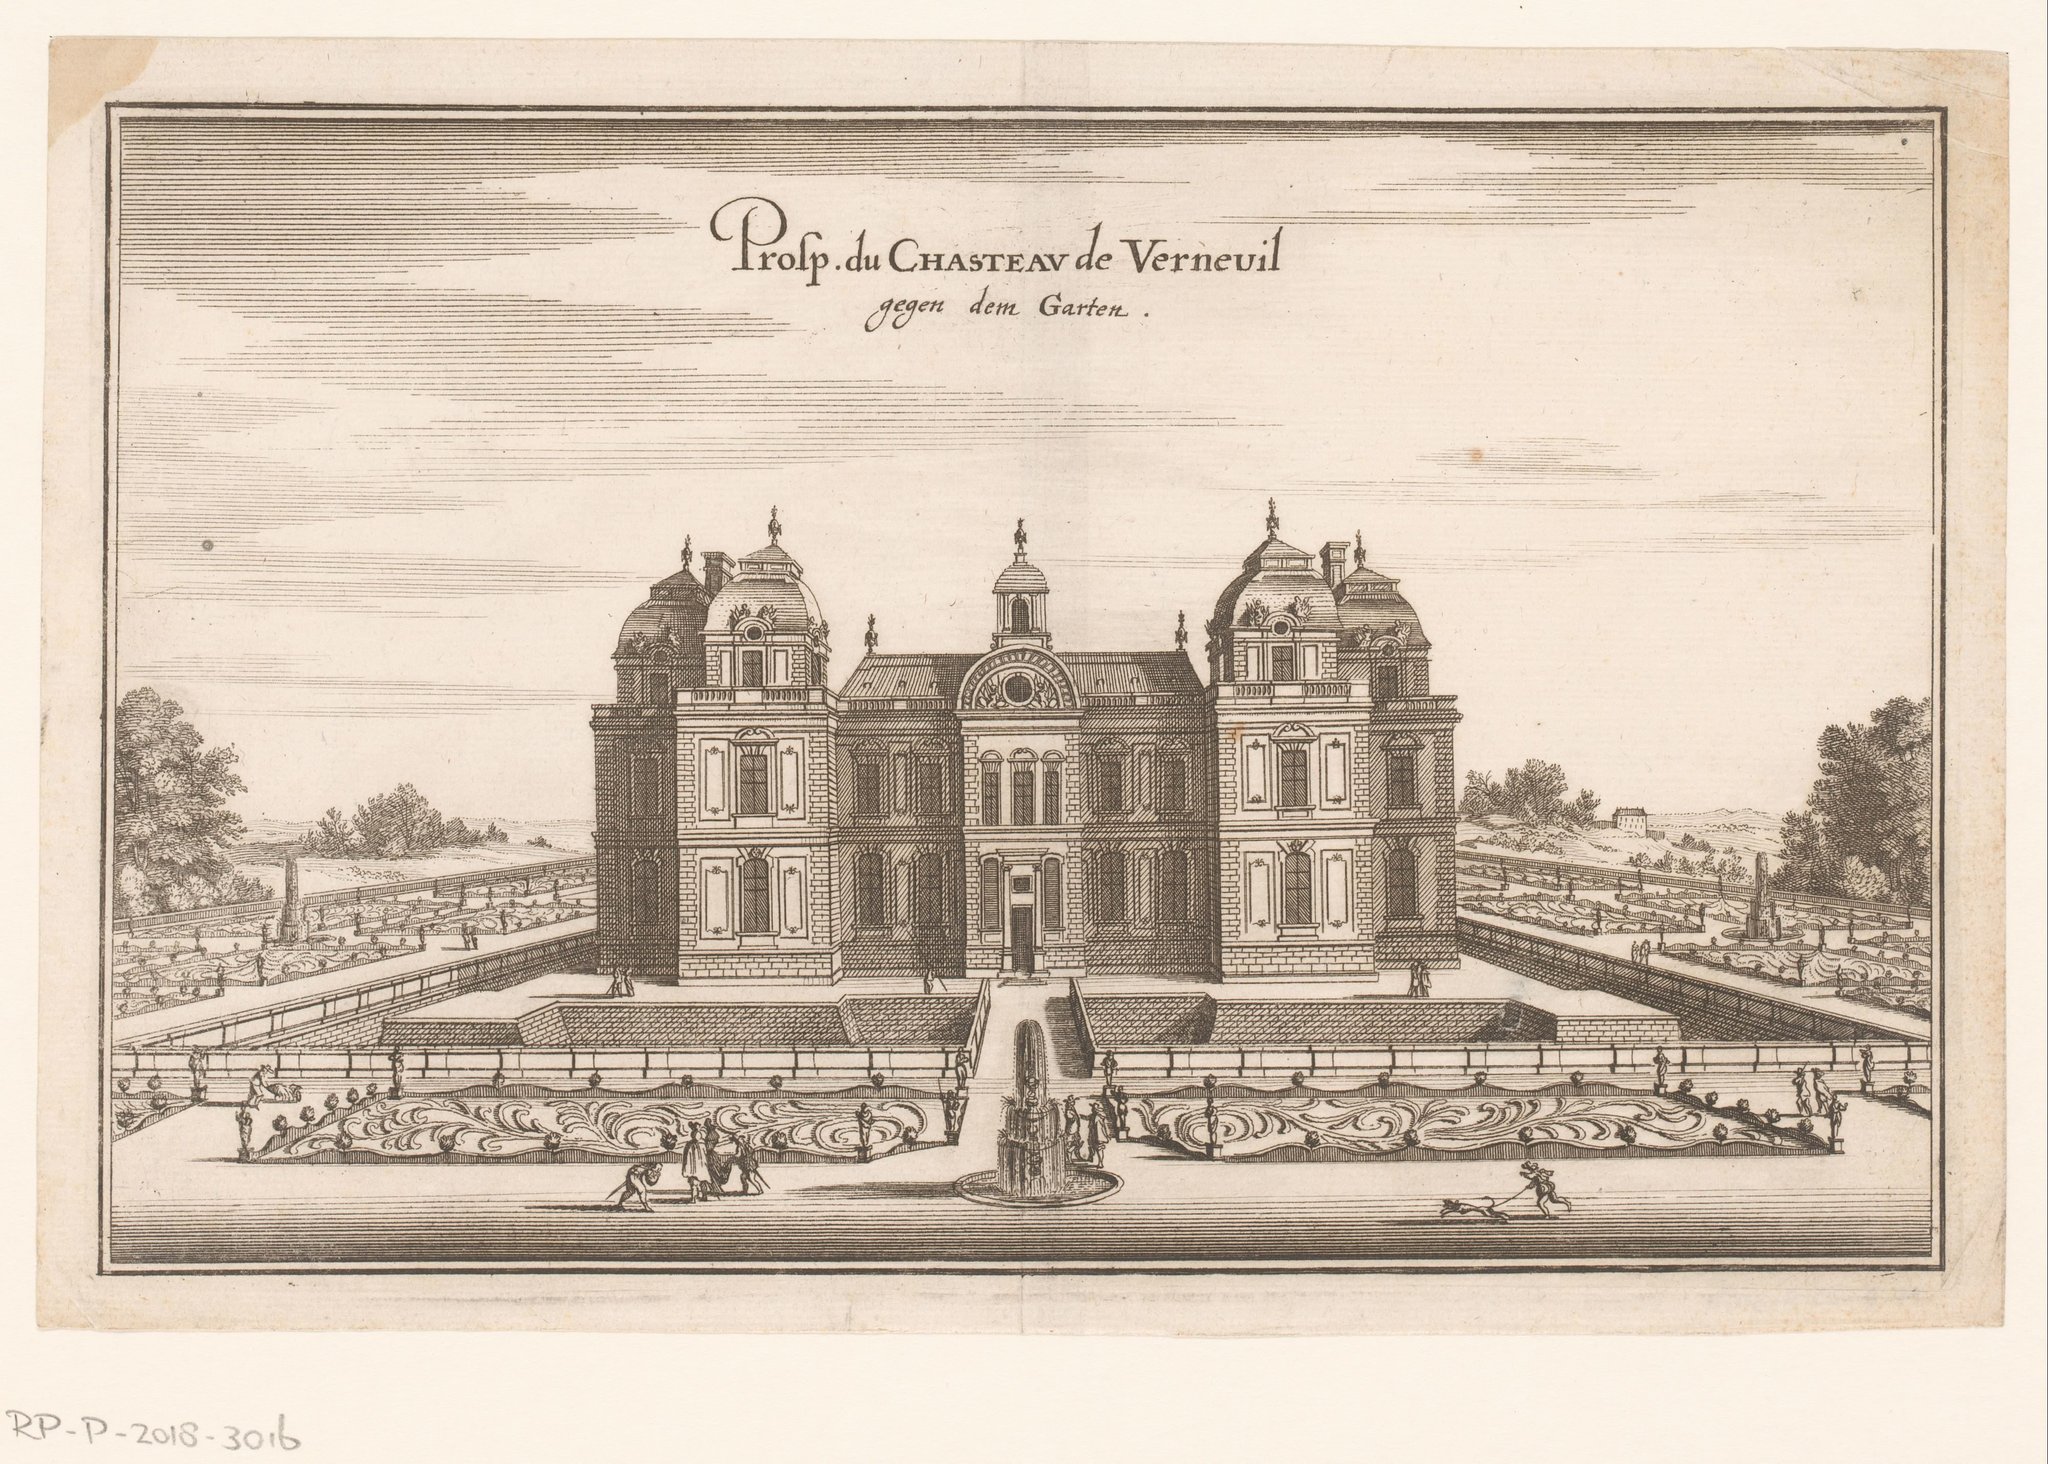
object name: print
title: Prosp. du Chasteau de Verneuil gegen dem Garten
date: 1655-1670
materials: paper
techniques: engraving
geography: frankfurt am main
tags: castle, landscape with tower or castle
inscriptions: collector's mark: Lugt 2228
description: Prent uit: Topographia Galliae. Frankfurt: Caspar Merian, 1655-1661, 13 dln. Dl. 1, prent 128. Naast hierboven beschreven editie is deze prent ook in latere edities gebruikt, tot ca. 1670. Tevens in de Nederlandstalige editie uitgegeven in Amsterdam: Wed. Joost van Broersz en Caspar Merian, 1660-1663, 4 dln.